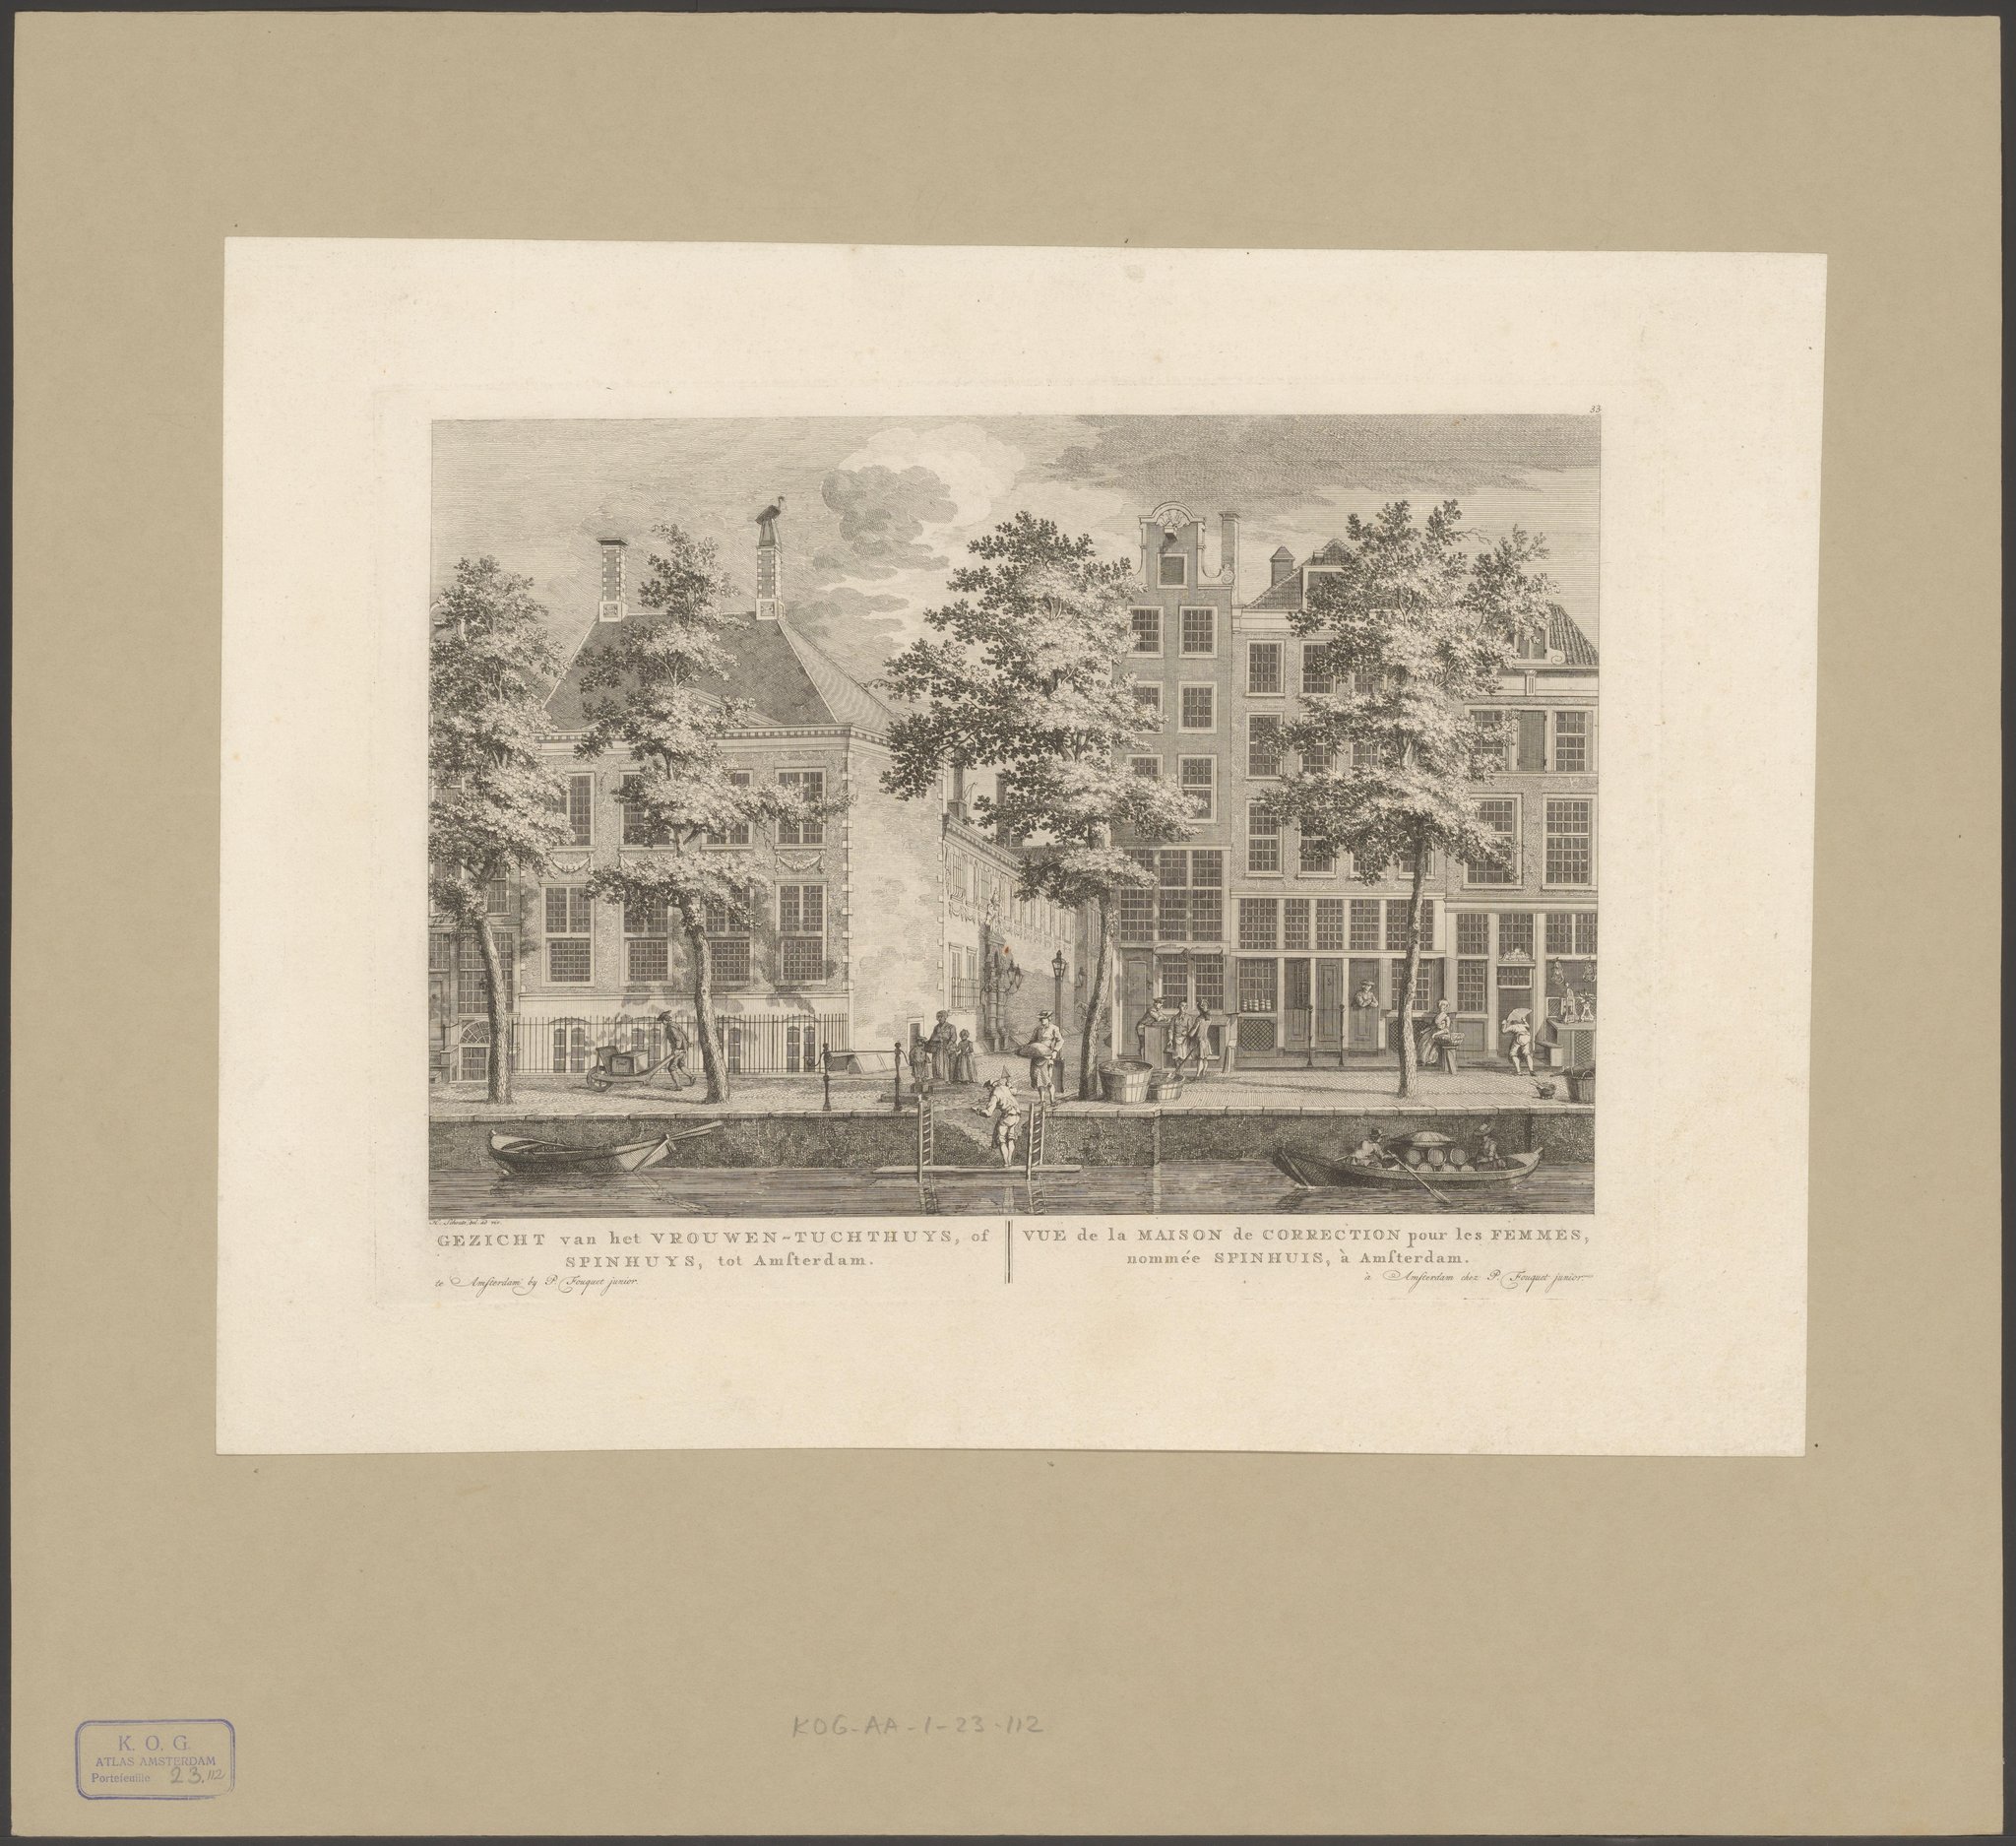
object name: print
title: Gezicht op het Spinhuis te Amsterdam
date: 1760-1783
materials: paper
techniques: engraving, etching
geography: amsterdam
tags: prison, jail, canals, waters (in city), workhouse, penal camp, penitentiary, chain gang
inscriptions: collector's mark: Lugt 1641b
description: Vanaf 1760 gaf Pierre Fouquet stadsgezichten van Amsterdam naar tekeningen van verschillende kunstenaars uit. Deze prenten werden aanvankelijk los verkocht. Later werden ze samengebonden verkocht in verschillende volgordes en aantallen in: (1). Afbeeldingen van de wyd-vermaarde koopstad Amsterdam benevens des zelvs voornaamste gebouwen en gezigten alle naar het leeven getekend / Receuil des edifices les plus considerables et des plus belles vues, de la fameuse ville d'Amsterdam, dessinées d'après nature. Amsterdam: Pierre Fouquet, 1778-1783. Deze 'uitgave' bestond waarschijnlijk alleen uit een titelblad en inhoudsopgave van de tot dusver 100 uitgegeven prenten, die de koper zelf aan zijn of haar reeds verzamelde prenten kon toevoegen. De hoeveelheid en volgorde van prenten verzameld onder deze titel verschilt dus sterk. (2). Nieuwe atlas, van de voornaamste gebouwen en gezigten der stad Amsterdam, met derzelver beknopte beschryvingen. 2 dln. Amsterdam: Daniël Jean Changuion en Petrus den Hengst [in opdracht van Pierre Fouquet], 1783. Ook werden er door verschillende uitgevers tussen 1788 (Amsterdam: Petrus Conradi) en 1805 (Amsterdam: Evert Maaskamp) heruitgaven gepubliceerd.